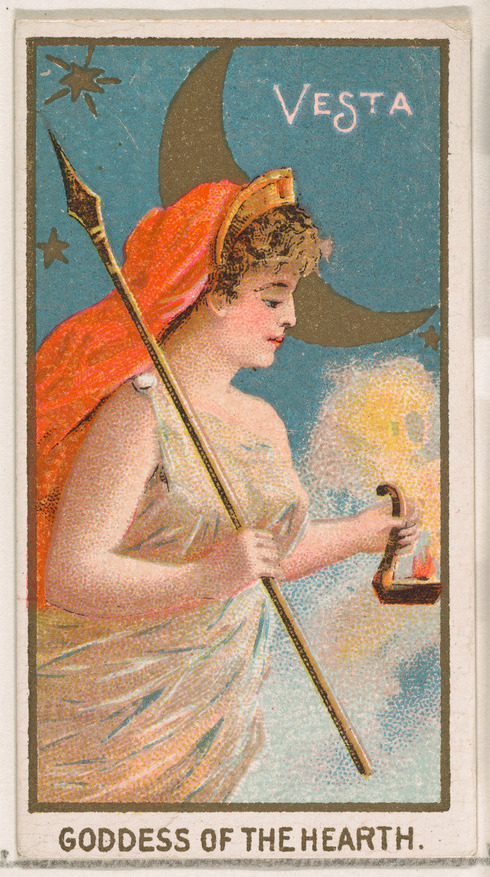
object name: print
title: Vesta, Goddess of the Hearth, from the Goddesses of the Greeks and Romans series (N188) issued by Wm. S. Kimball & Co.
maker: william s. kimball & company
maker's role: publisher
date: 1889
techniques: color lithograph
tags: goddess